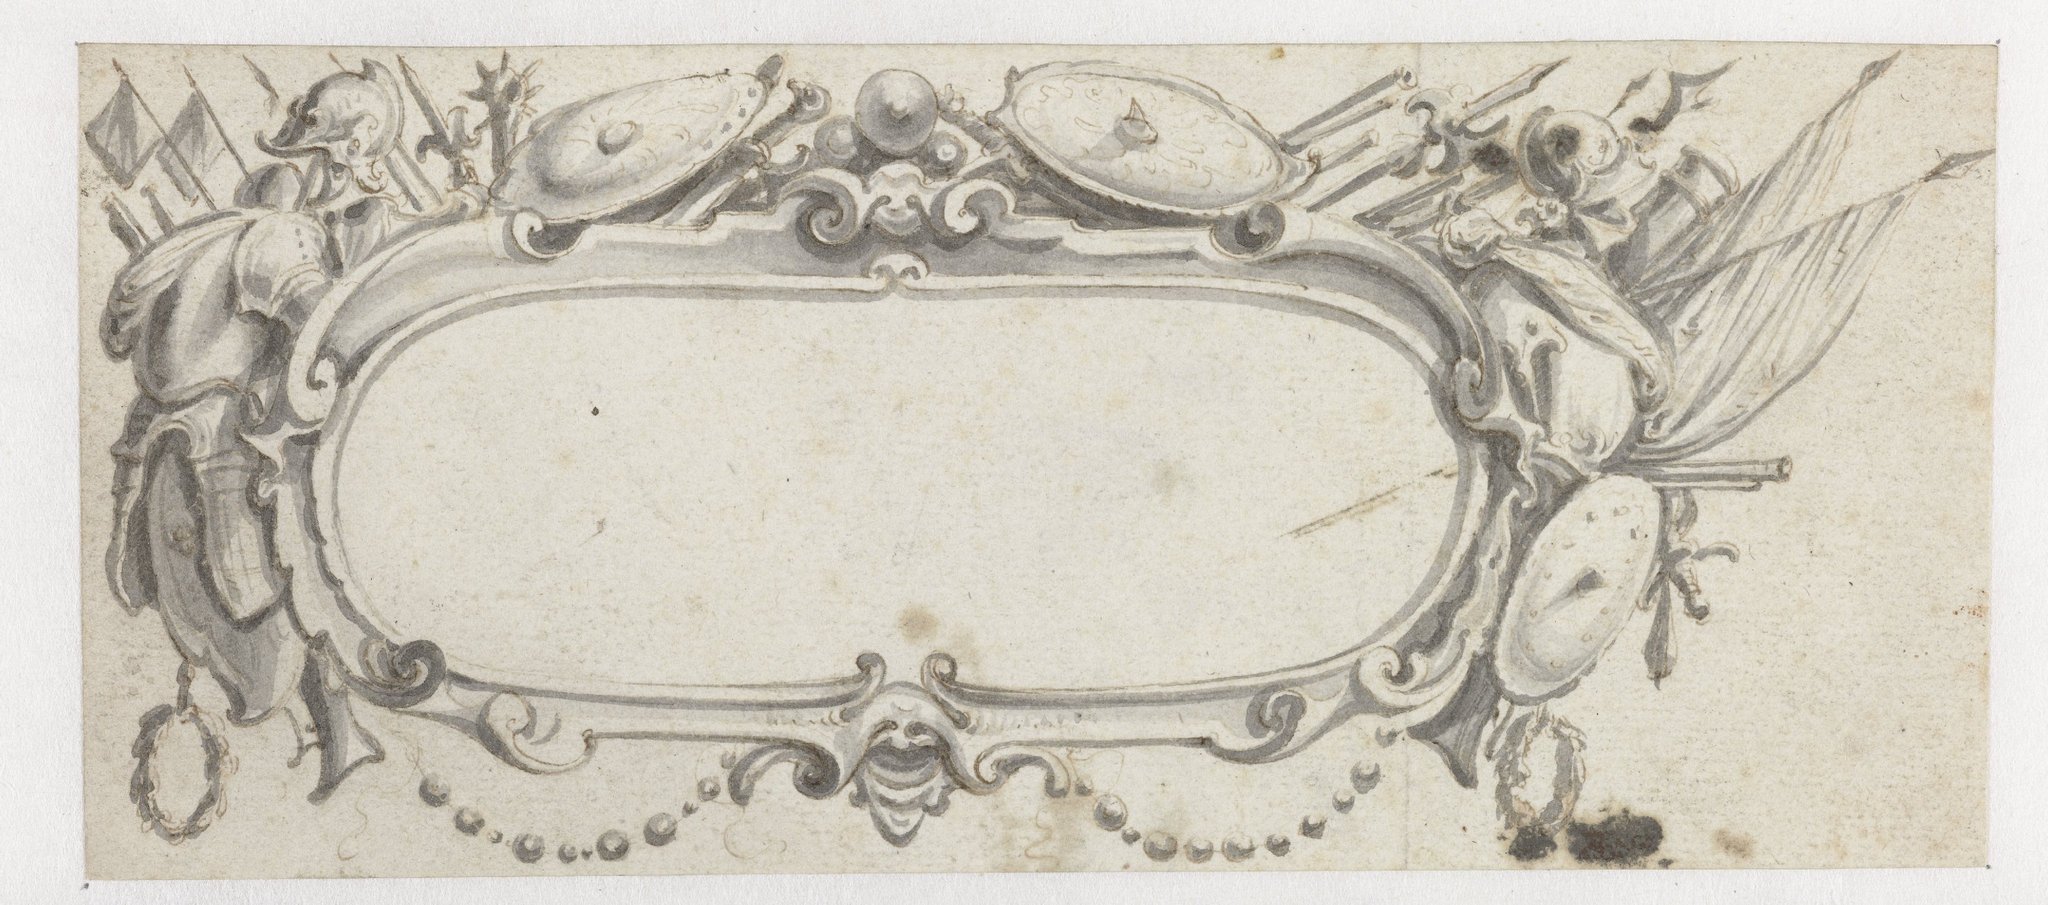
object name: design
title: Ovale cartouche omringd met wapentuig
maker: pieter jansz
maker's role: draughtsman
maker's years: 1602-1672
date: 1630-1672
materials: ink, paper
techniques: brush, pen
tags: weapons, ornament ~ cartouche, (other) ornaments derived from objects